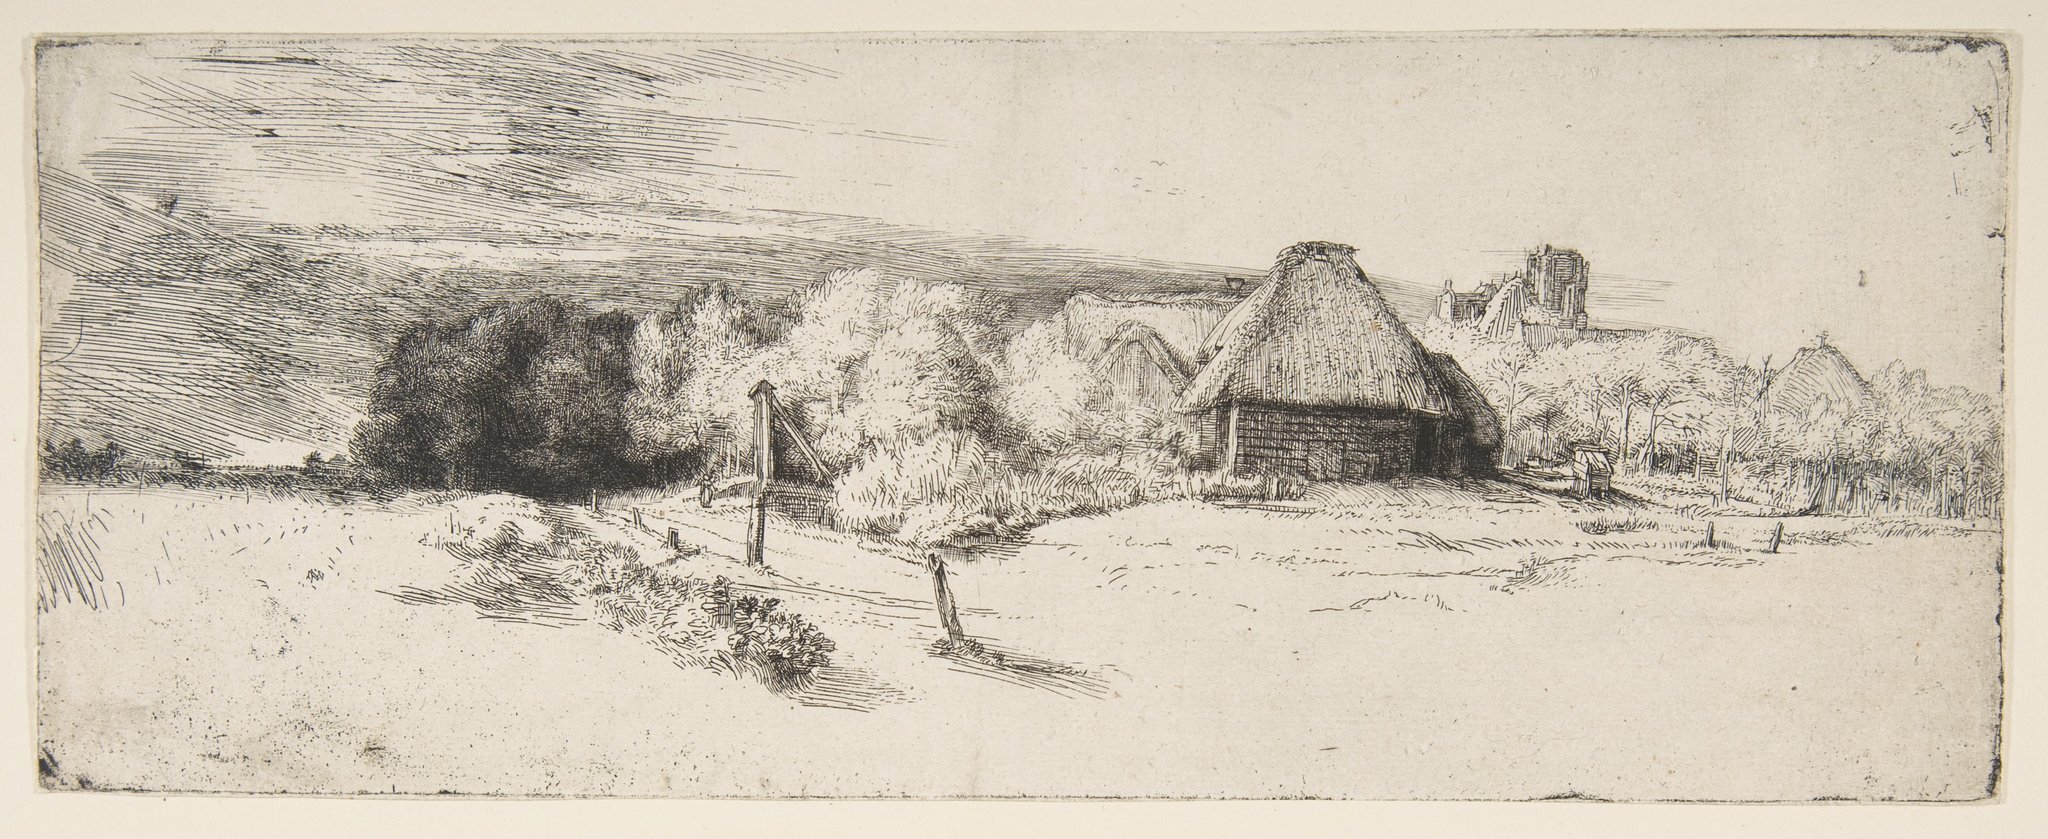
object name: print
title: Landscape with Trees, Farm Buildings, and a Tower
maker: rembrandt van rijn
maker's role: artist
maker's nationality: dutch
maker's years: 1606-1669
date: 1651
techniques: drypoint, etching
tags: farms,landscapes